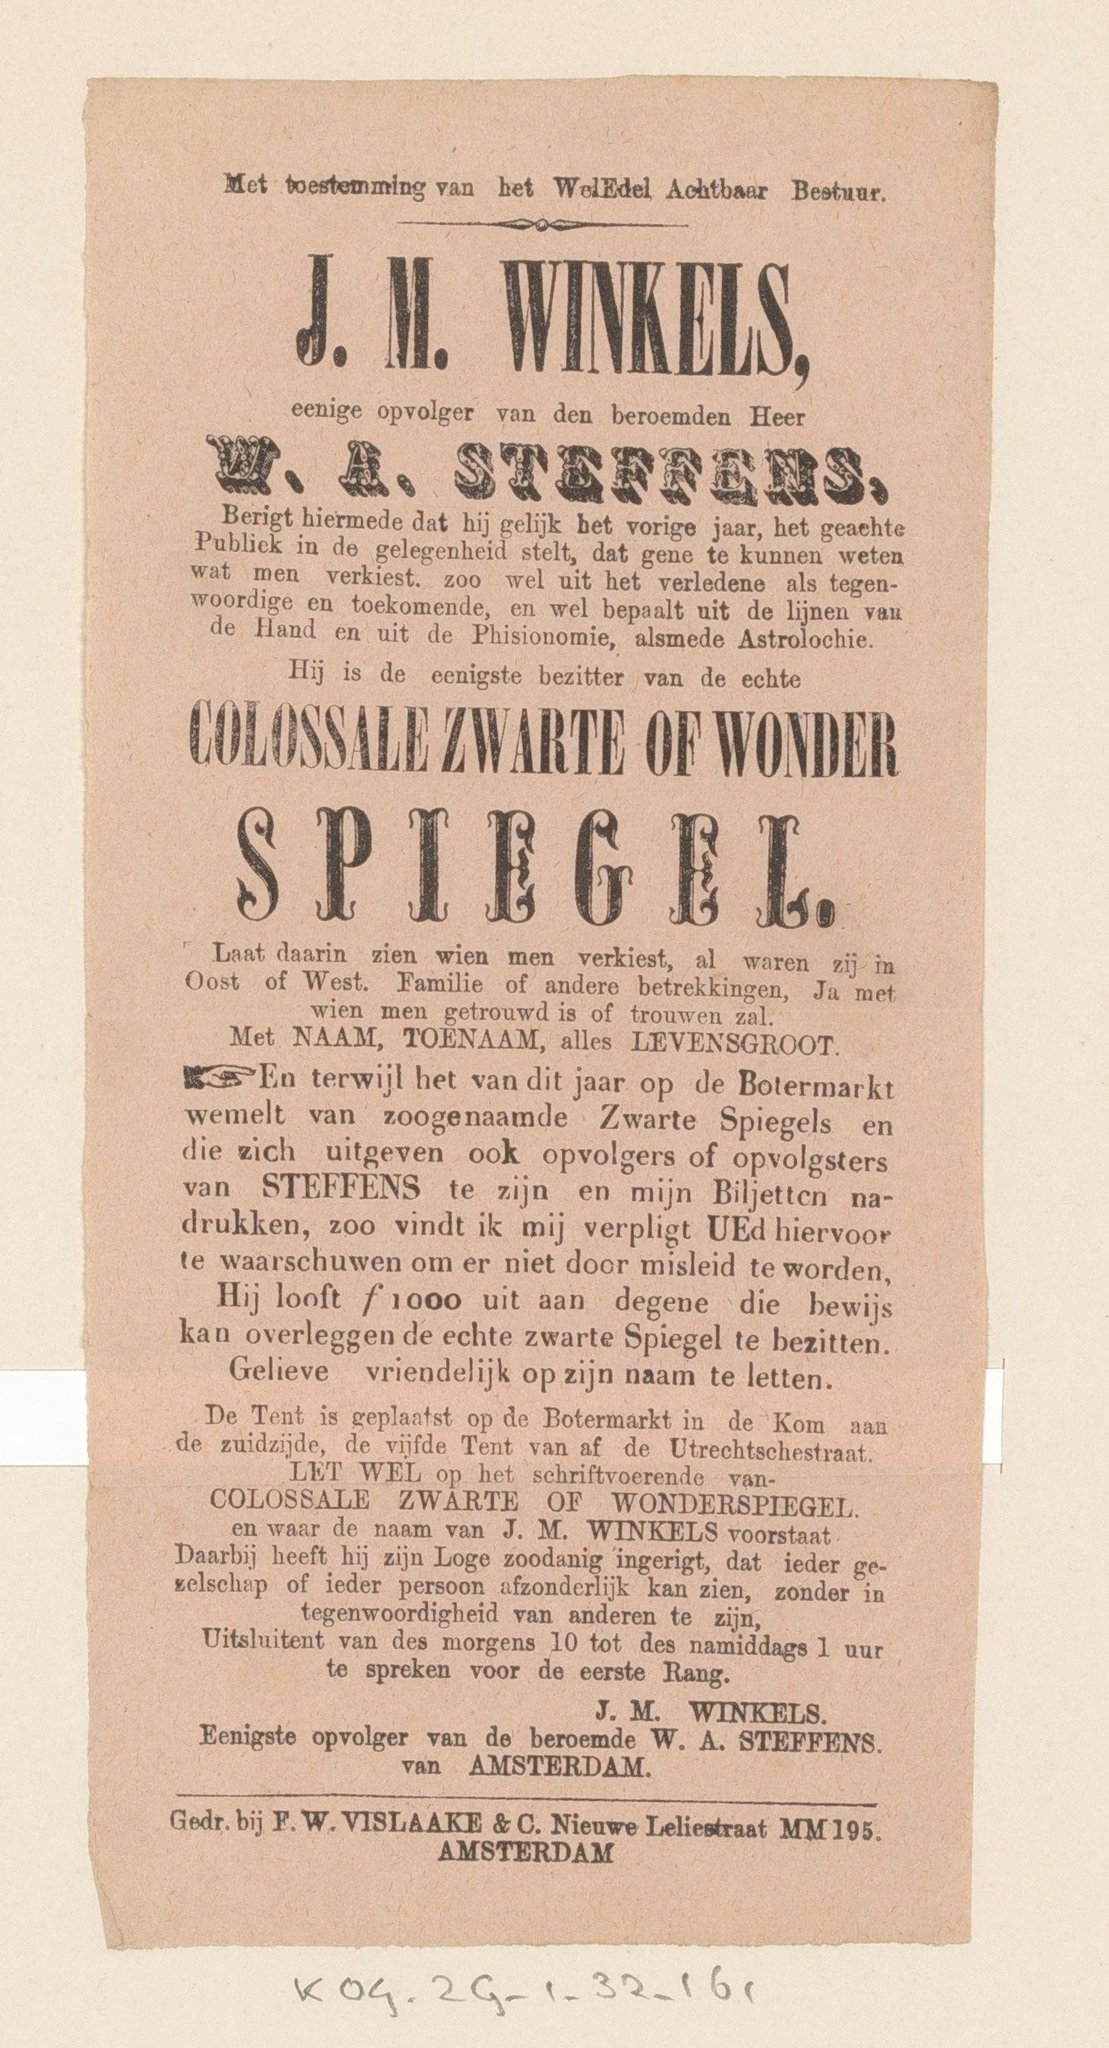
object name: text sheet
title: J.M. Winkels (...) eenigste bezitter van de echte Colossale Zwarte of Wonder Spiegel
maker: f.w. vislaake & co.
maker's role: drukkerij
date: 1852-1857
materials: paper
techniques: letterpress printing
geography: amsterdam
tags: illusionist, conjurer, juggler, 'legerdemain', fortune-teller ~ pleasure fair and circus, pleasure fair and circus, amsterdam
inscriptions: collector's mark, collector's mark: Lugt 1641